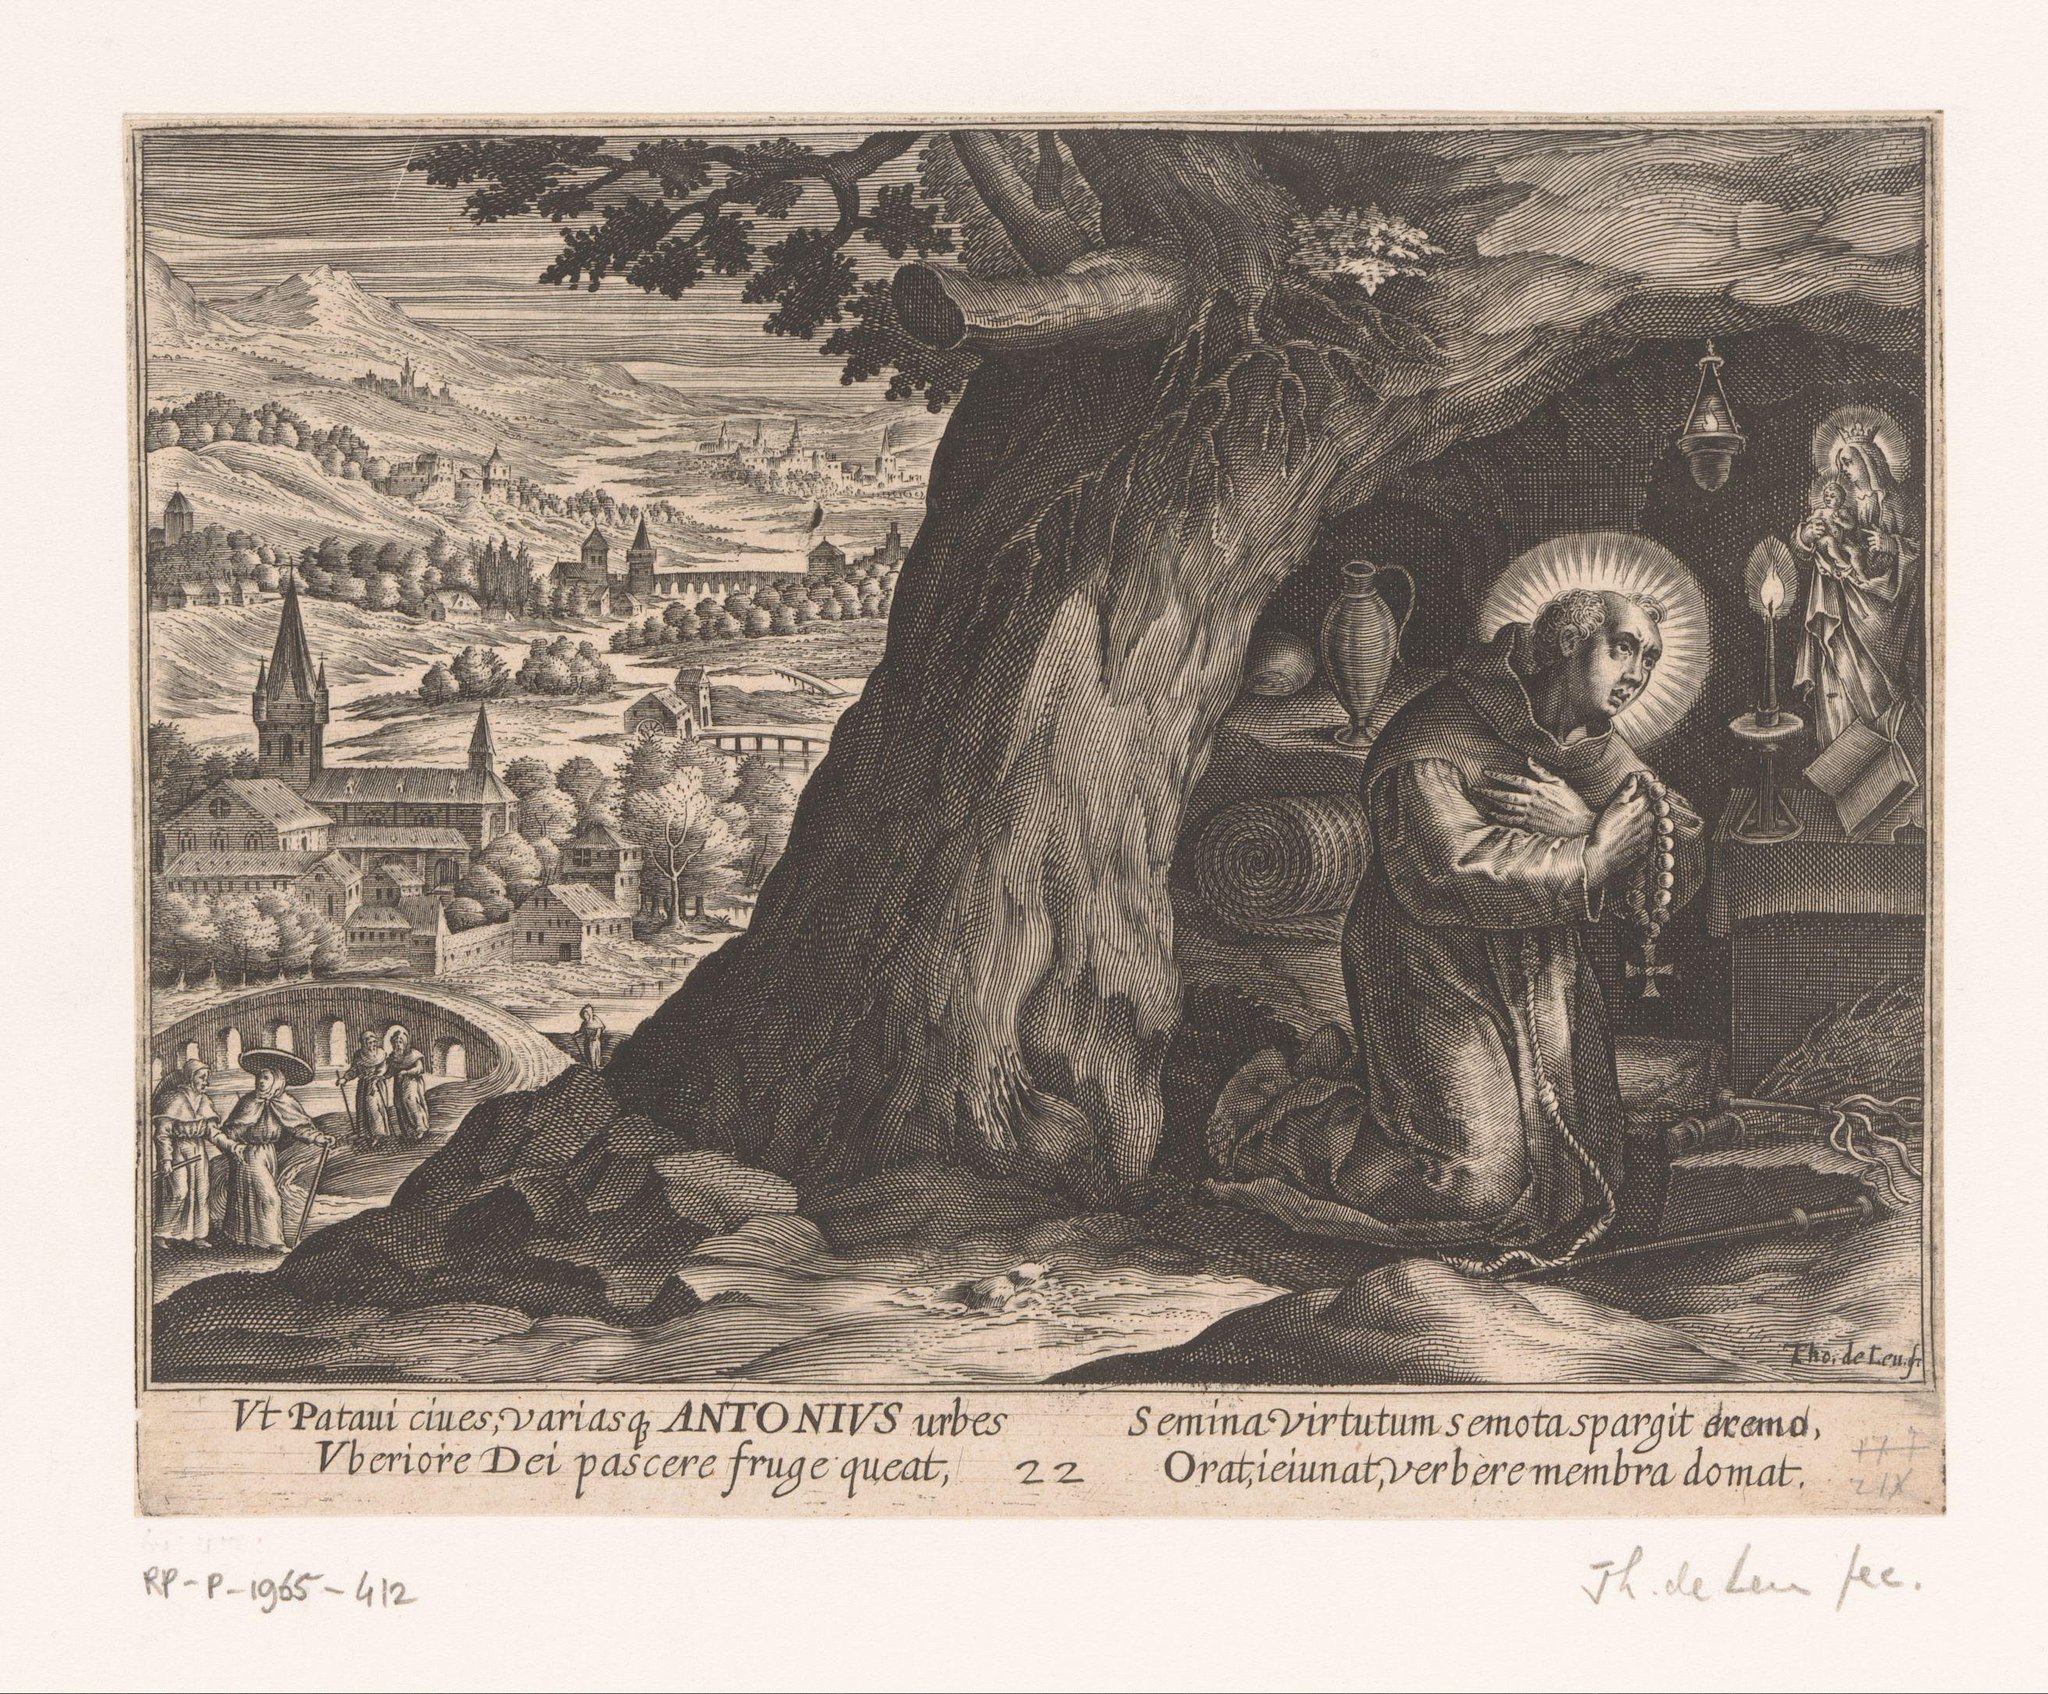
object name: print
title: Trophaeum Vitae solitariae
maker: thomas de leu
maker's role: print maker, publisher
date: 1598-1614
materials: paper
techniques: engraving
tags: personal devotion of st. antony of padua - renouncing worldly goods, ascetic life of male saint, anchorite, hermit, cave, grotto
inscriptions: collector's mark: Lugt 2228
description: Maakt deel uit van een 24-delige serie met titelprent, over het leven van kluizenaars en heremieten naar ontwerp door Maerten de Vos, Johann (I) en Raphaël Sadeler (I), uitgegeven door Thomas de Leu.